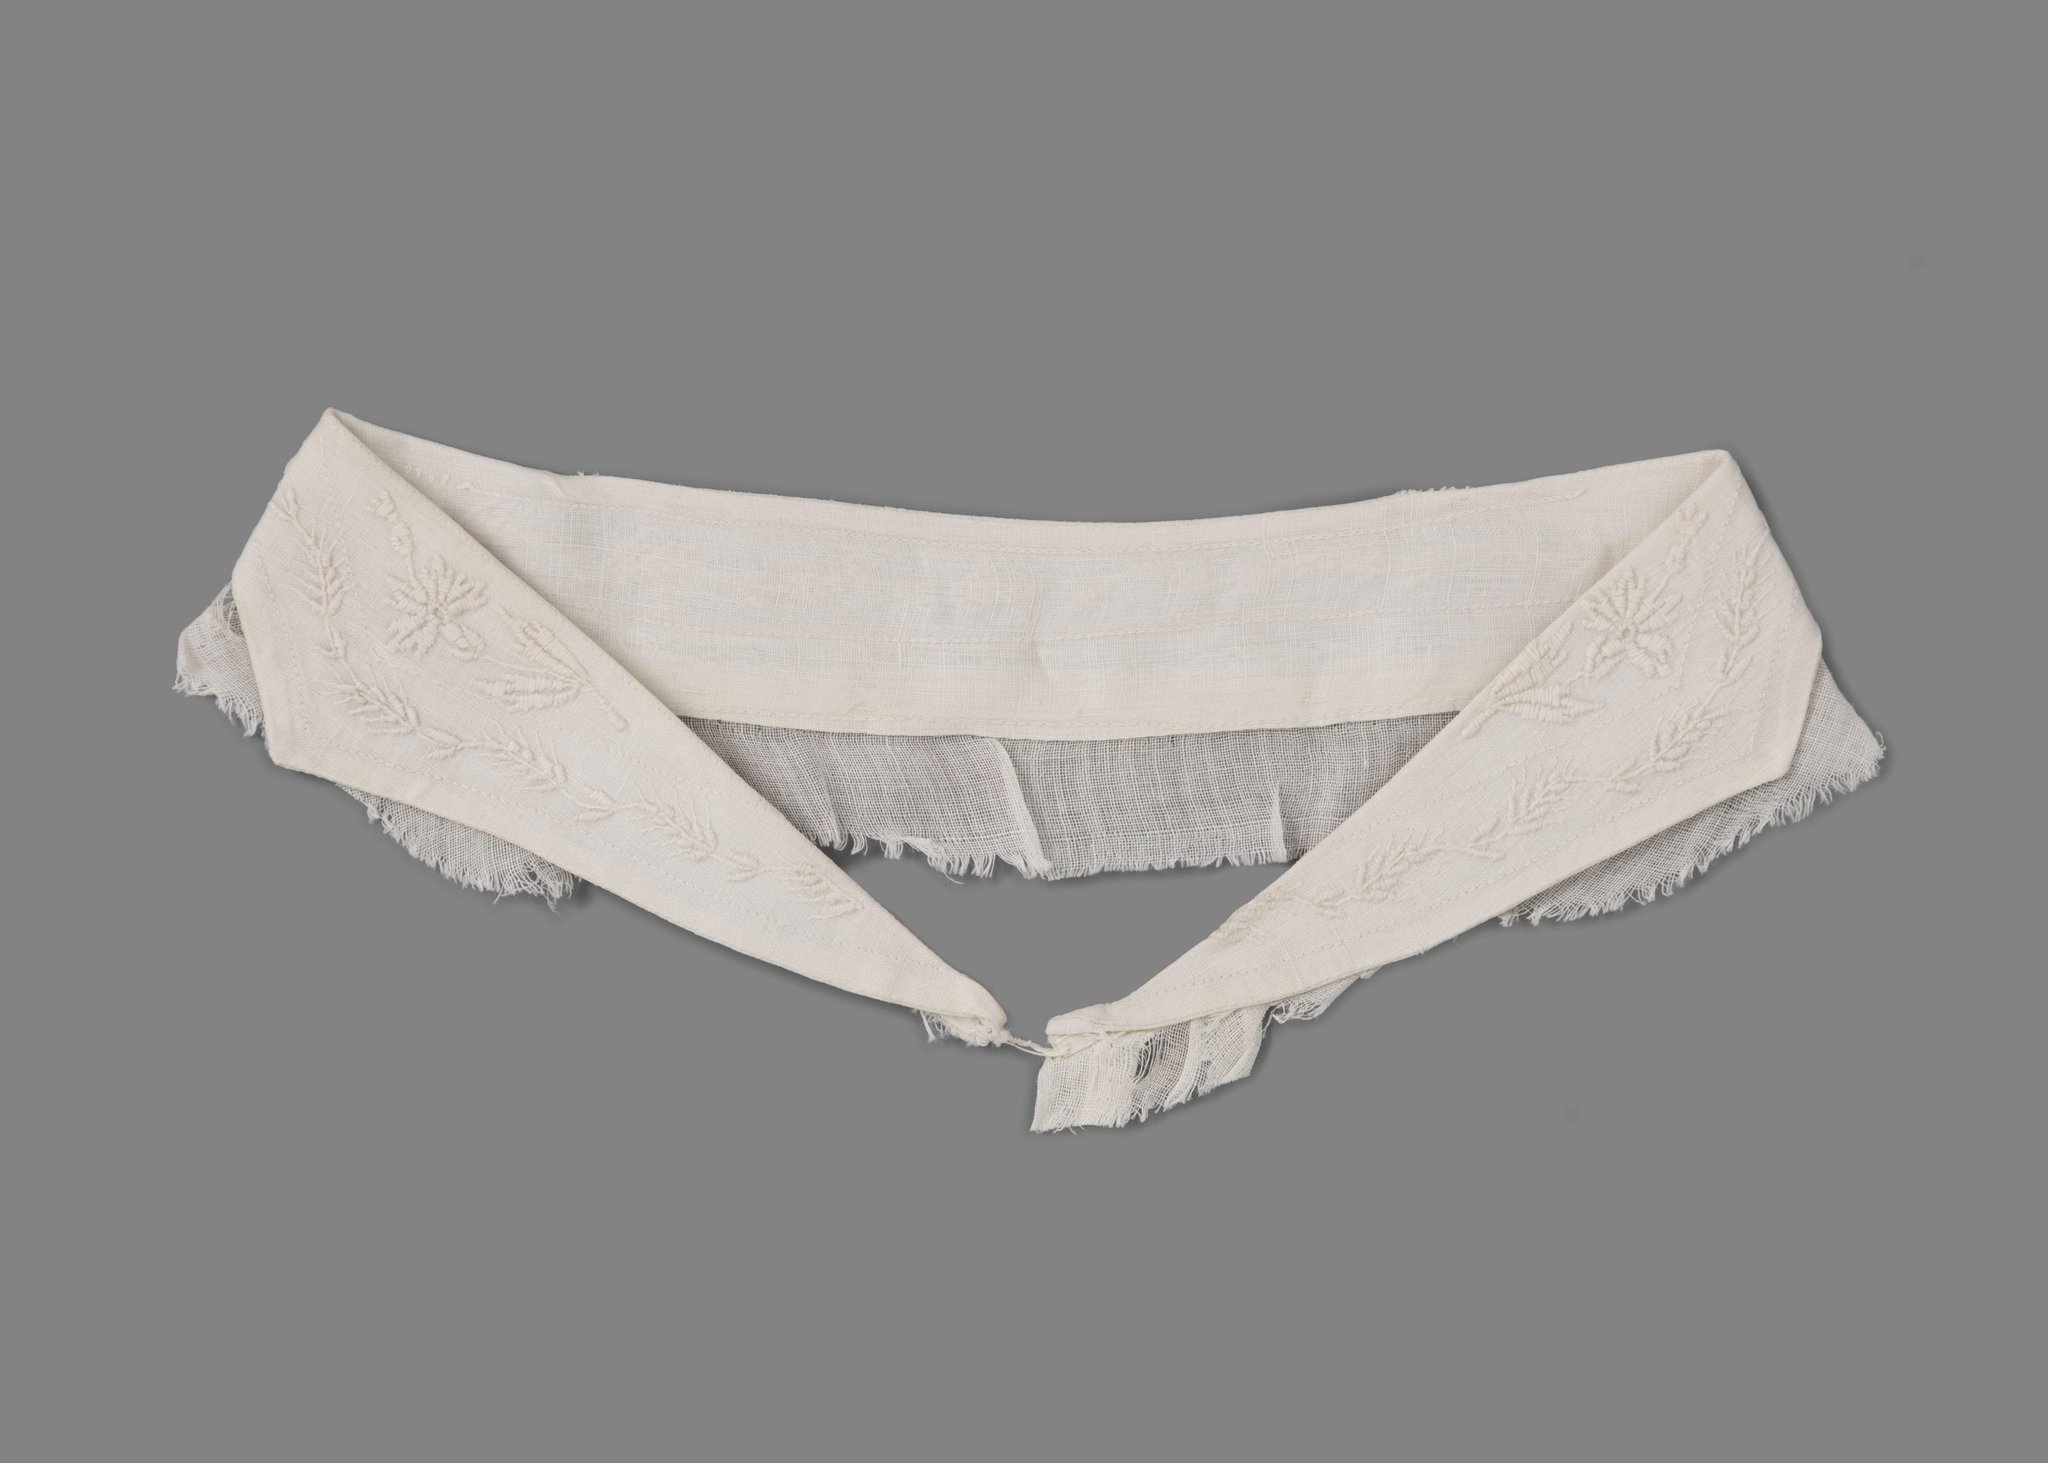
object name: womenswear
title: Kraag van gesteven katoen met staande boord en twee omslagpunten met in witwerk korenaren en -ranken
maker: Anonymous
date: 1875-1900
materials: cotton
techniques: embroidered, embroidery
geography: western europe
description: Kraag van katoen, staande boord met twee omslagpunten. Op koord en omslagen zijn ranken met korenaren geborduurd. In de driehoek een korenbloem.